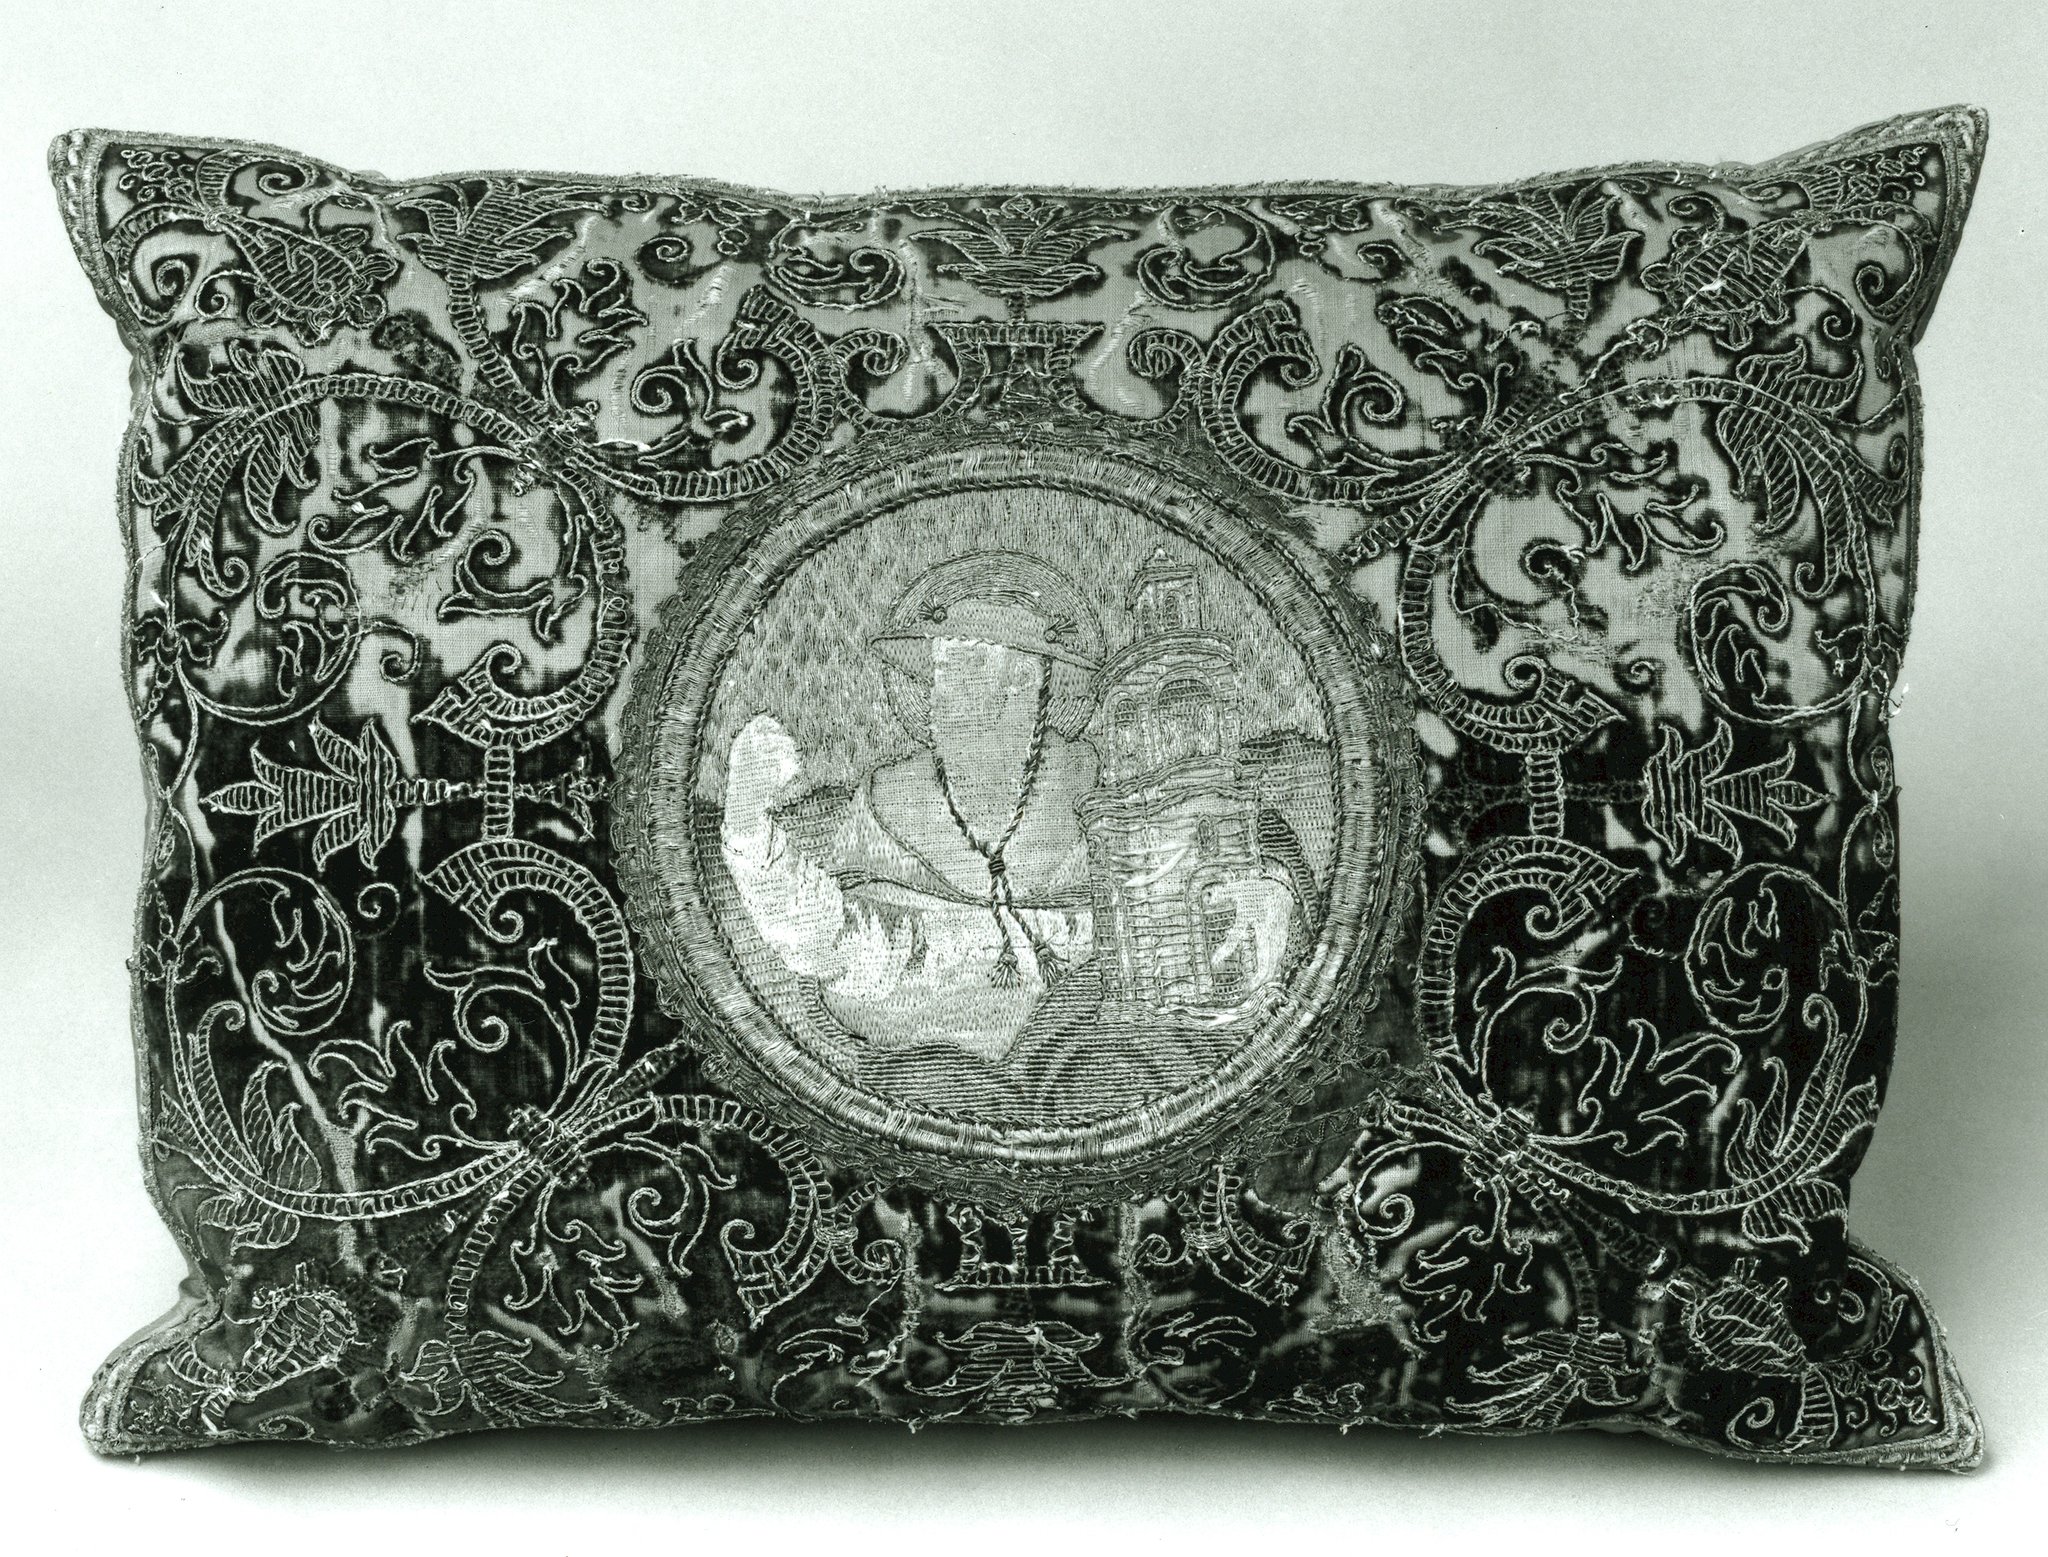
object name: roundel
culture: italian or spanish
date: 1401-1500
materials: gilt, linen, metal, metal thread, silk, velvet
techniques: embroidery, cutting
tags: men